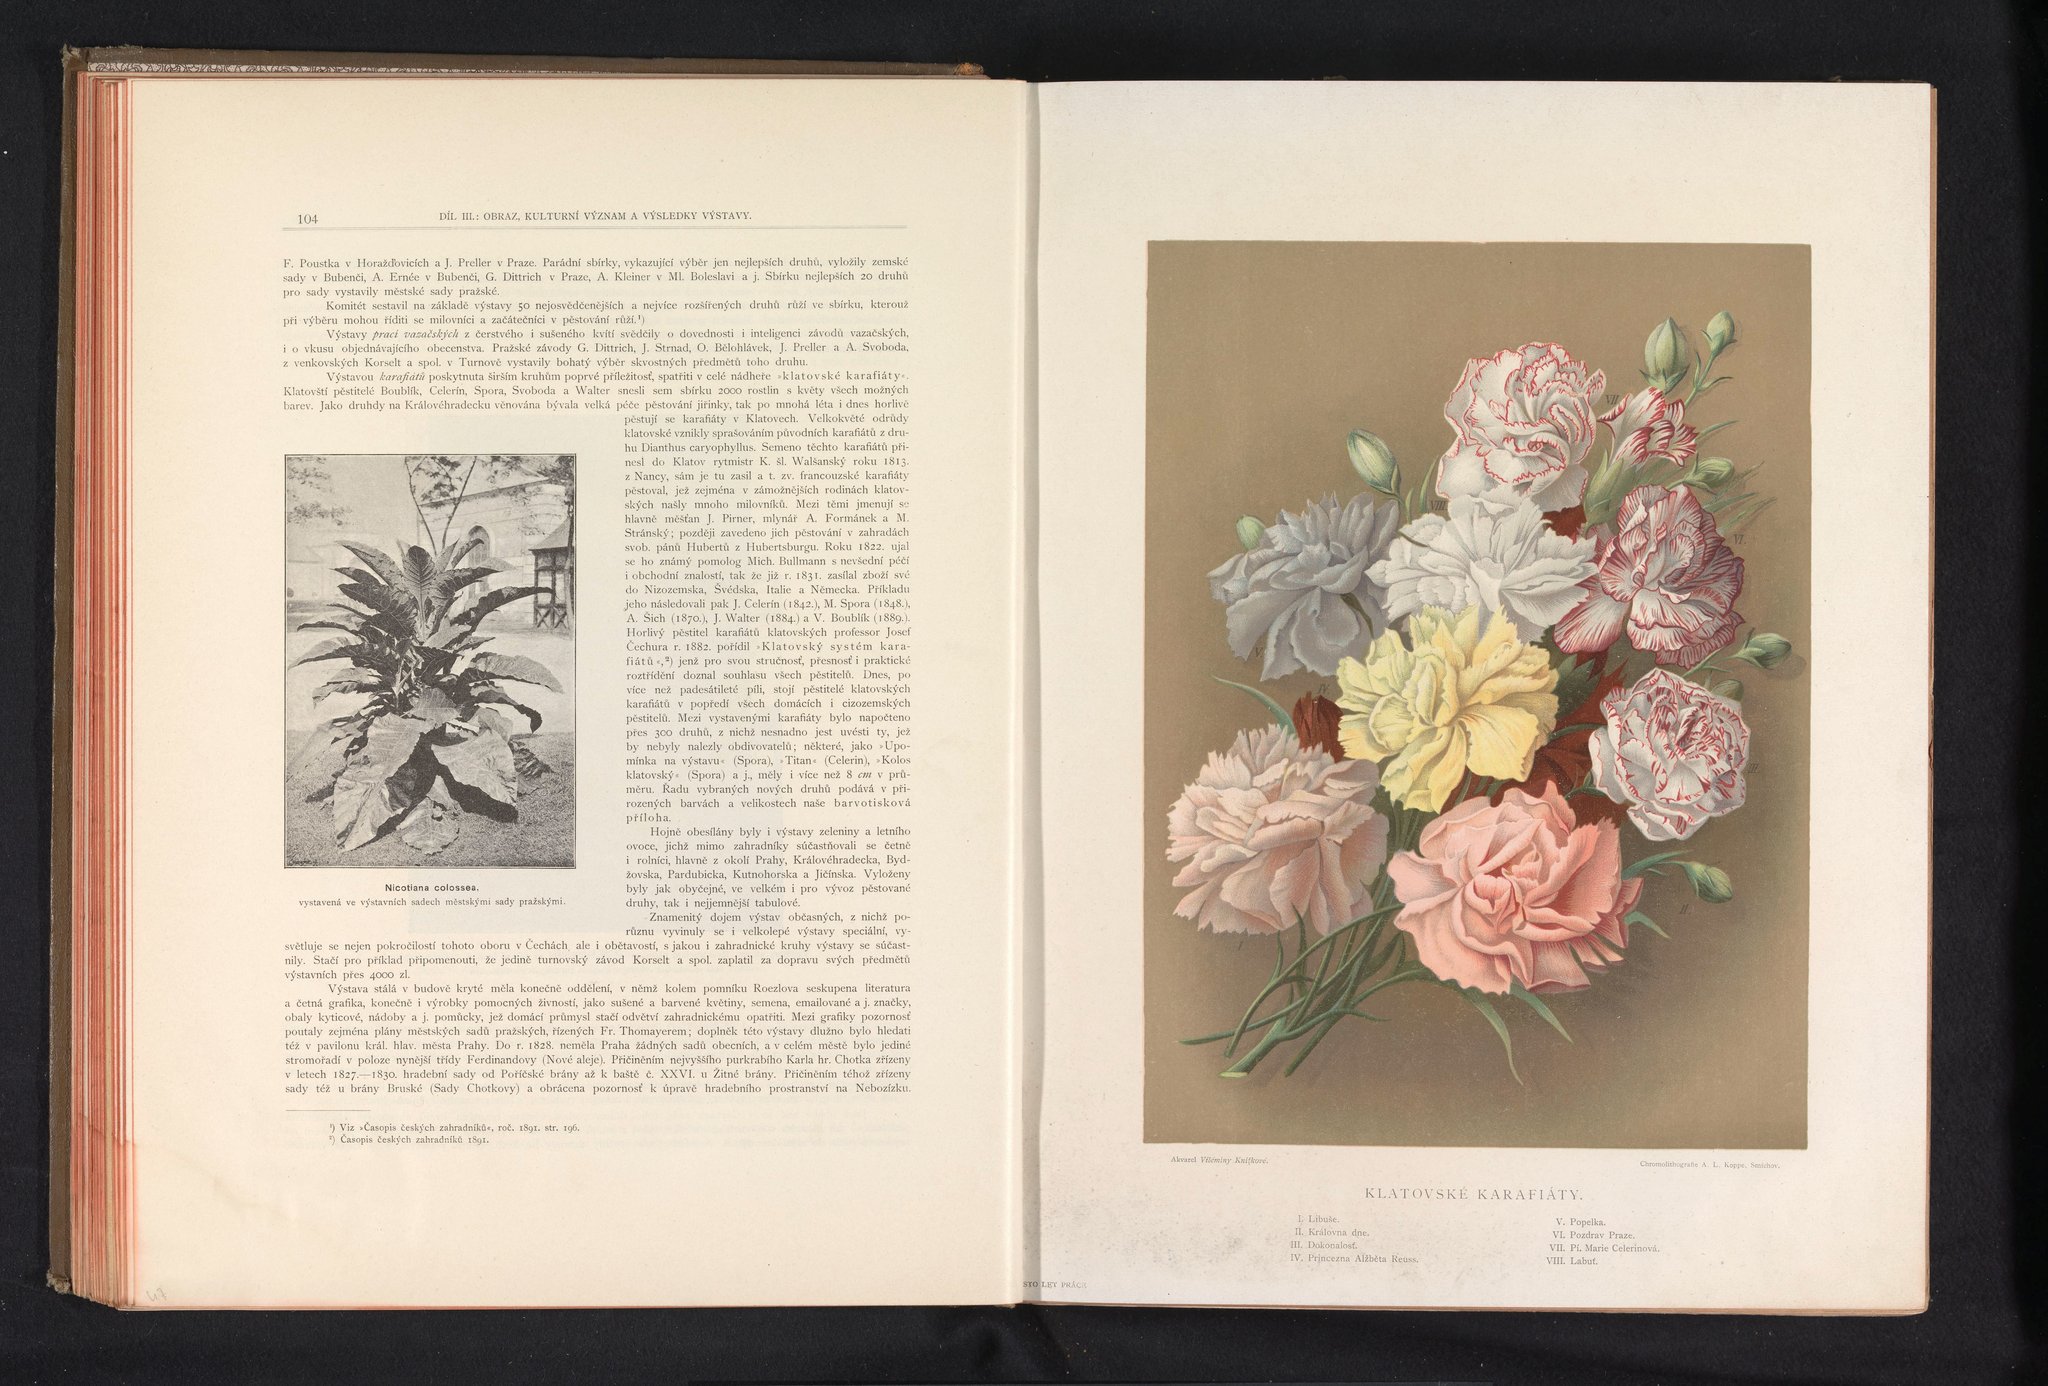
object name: photomechanical print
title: Nicotiana colossea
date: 1891-1895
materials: paper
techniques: autotype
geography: prague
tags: plants; vegetation, tobacco